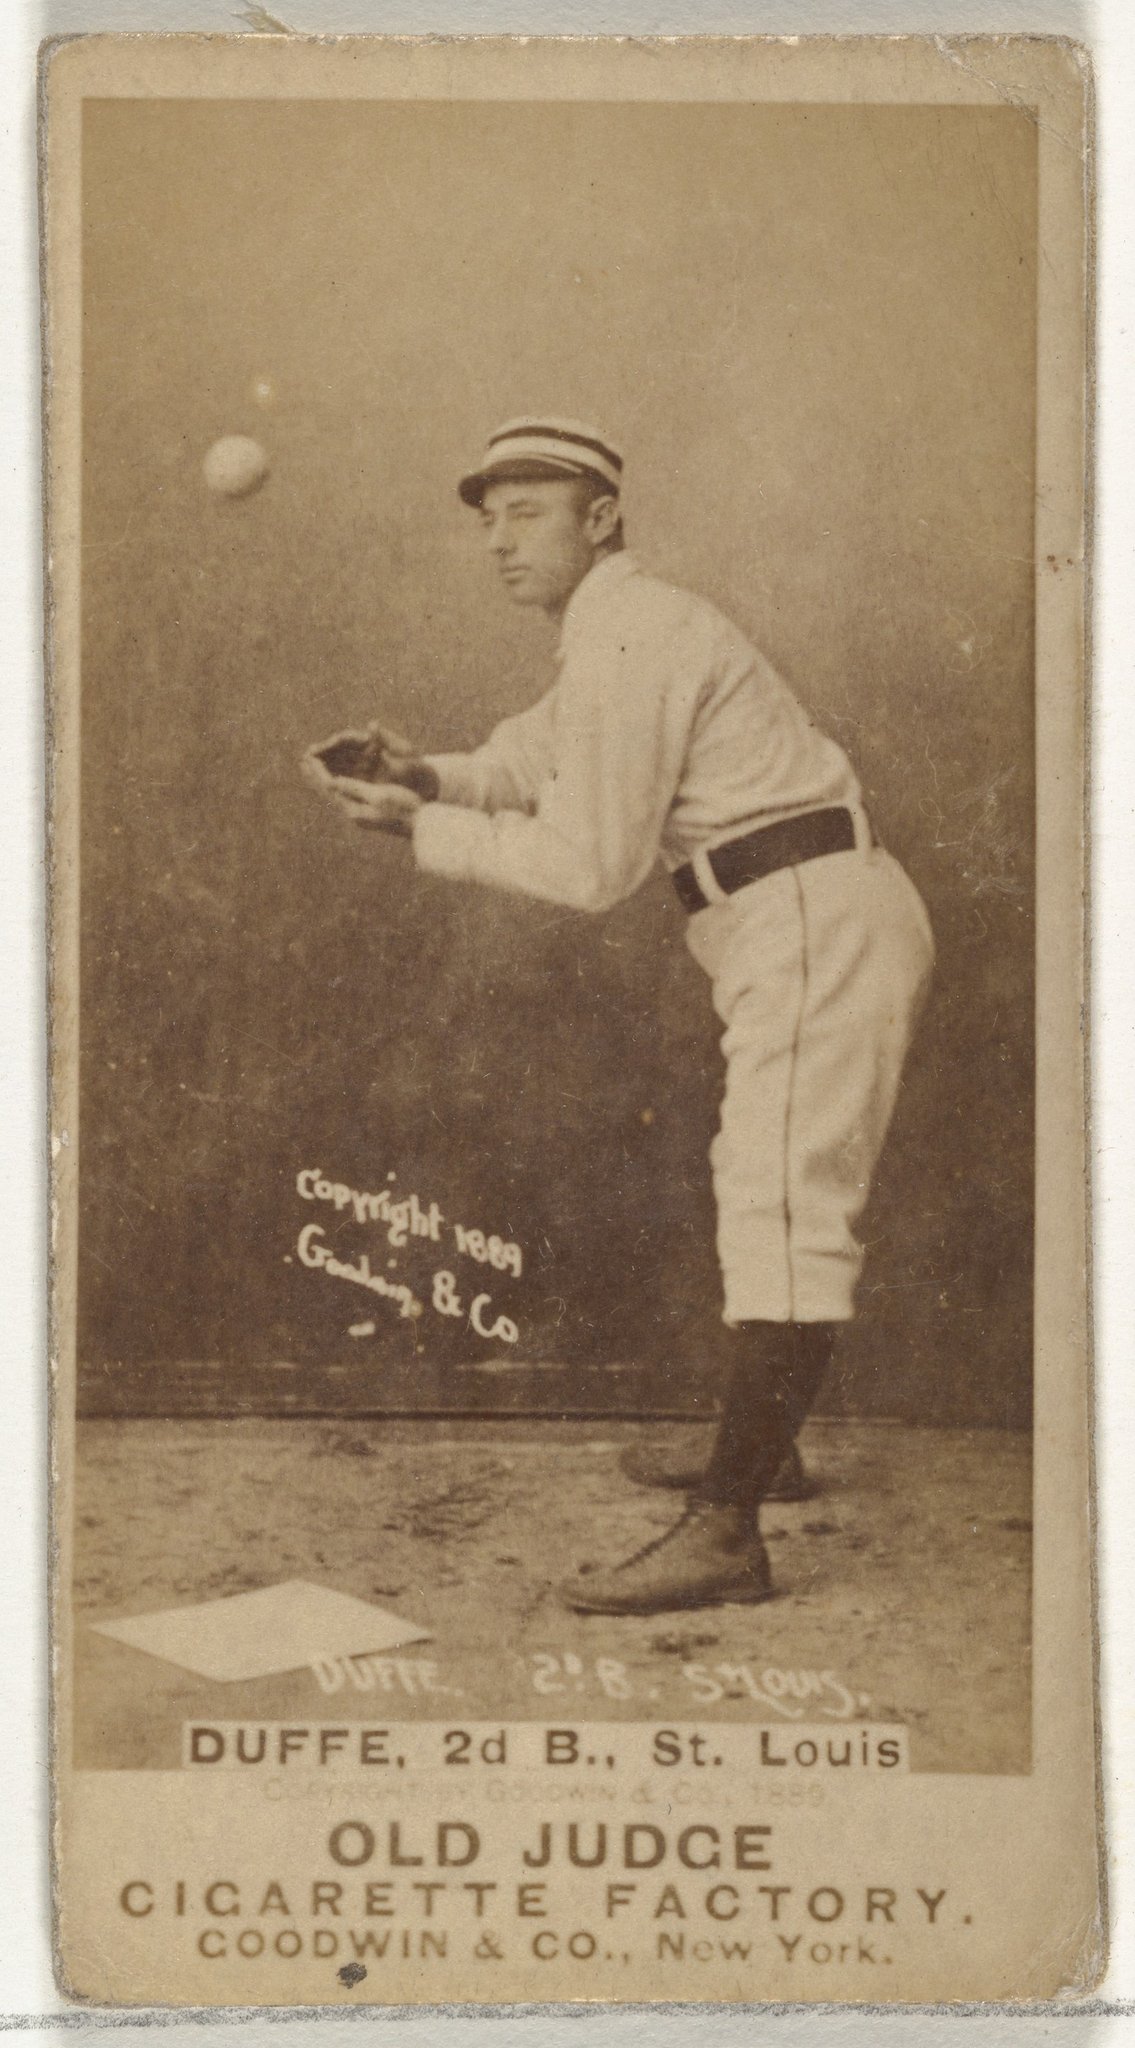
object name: baseball card, photograph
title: Charles Edward "Charlie" Duffee, 2nd Base, St. Louis Browns, from the Old Judge series (N172) for Old Judge Cigarettes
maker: goodwin & company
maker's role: publisher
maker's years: 1850-1950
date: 1889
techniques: albumen silver print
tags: men,portraits,baseball,athletes